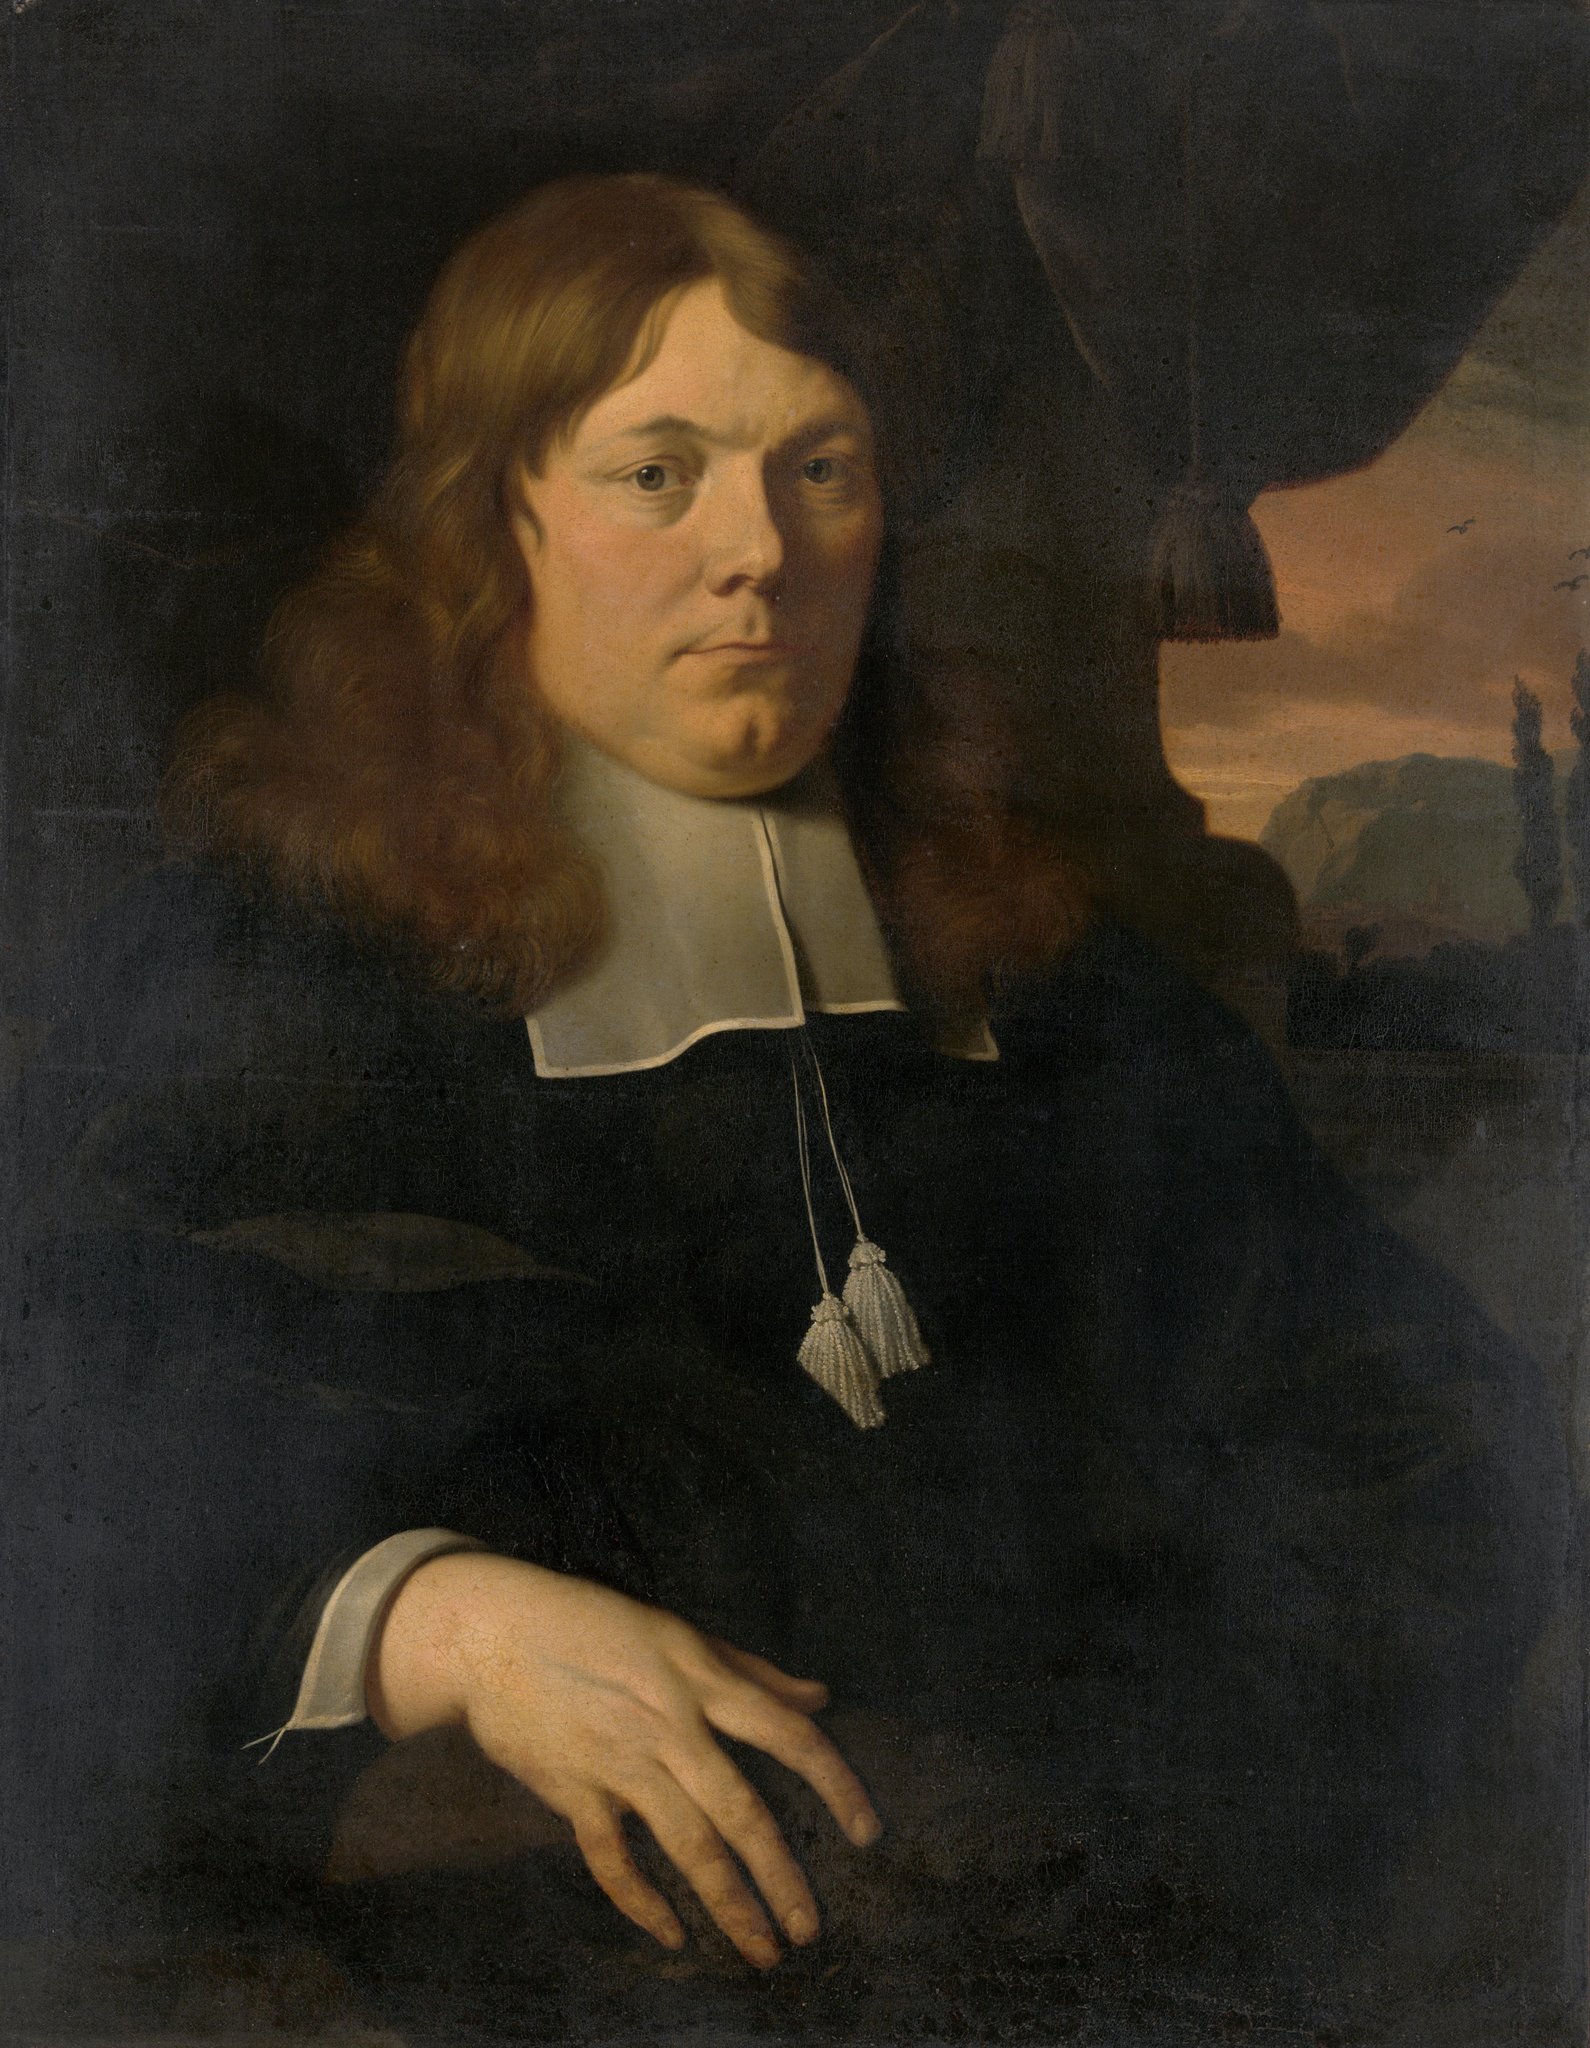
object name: painting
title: Portrait of a Man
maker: ary de vois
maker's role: painter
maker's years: 1632-1680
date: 1660-1680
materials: canvas, oil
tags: historical persons not known by name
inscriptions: signature: ‘ADVois f.’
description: Portret van een man. Ten halven lijve, zittend voor een balustrade, op de achtergrond een landschap.